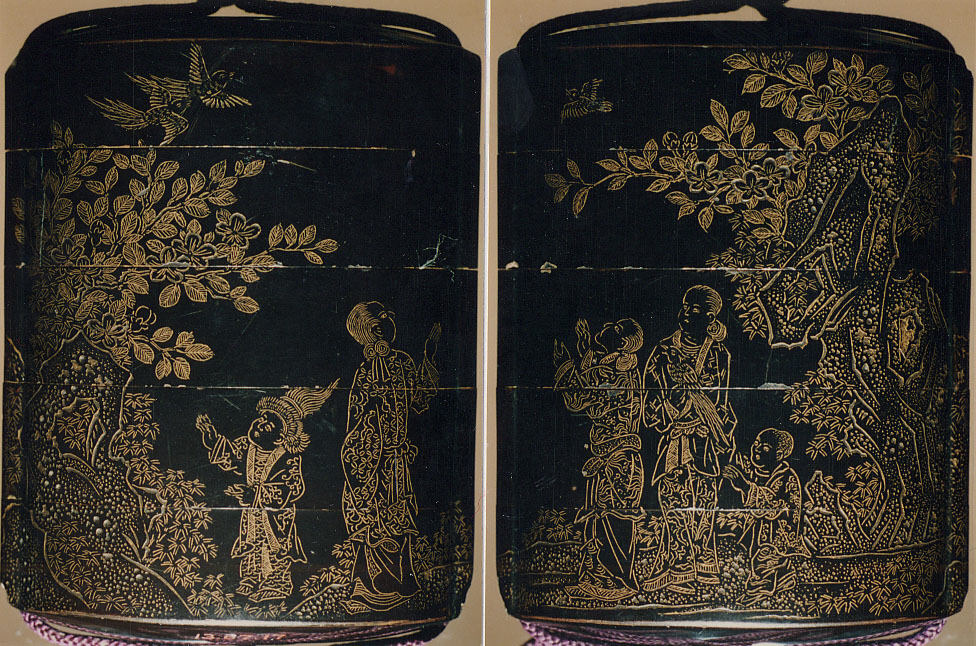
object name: inrō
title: Case (Inrō) with Design of Chinese Women at Court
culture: japanese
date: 1767-1833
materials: wood, gold, lacquer, stone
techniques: carving, incising, roiro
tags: human figures,birds,trees